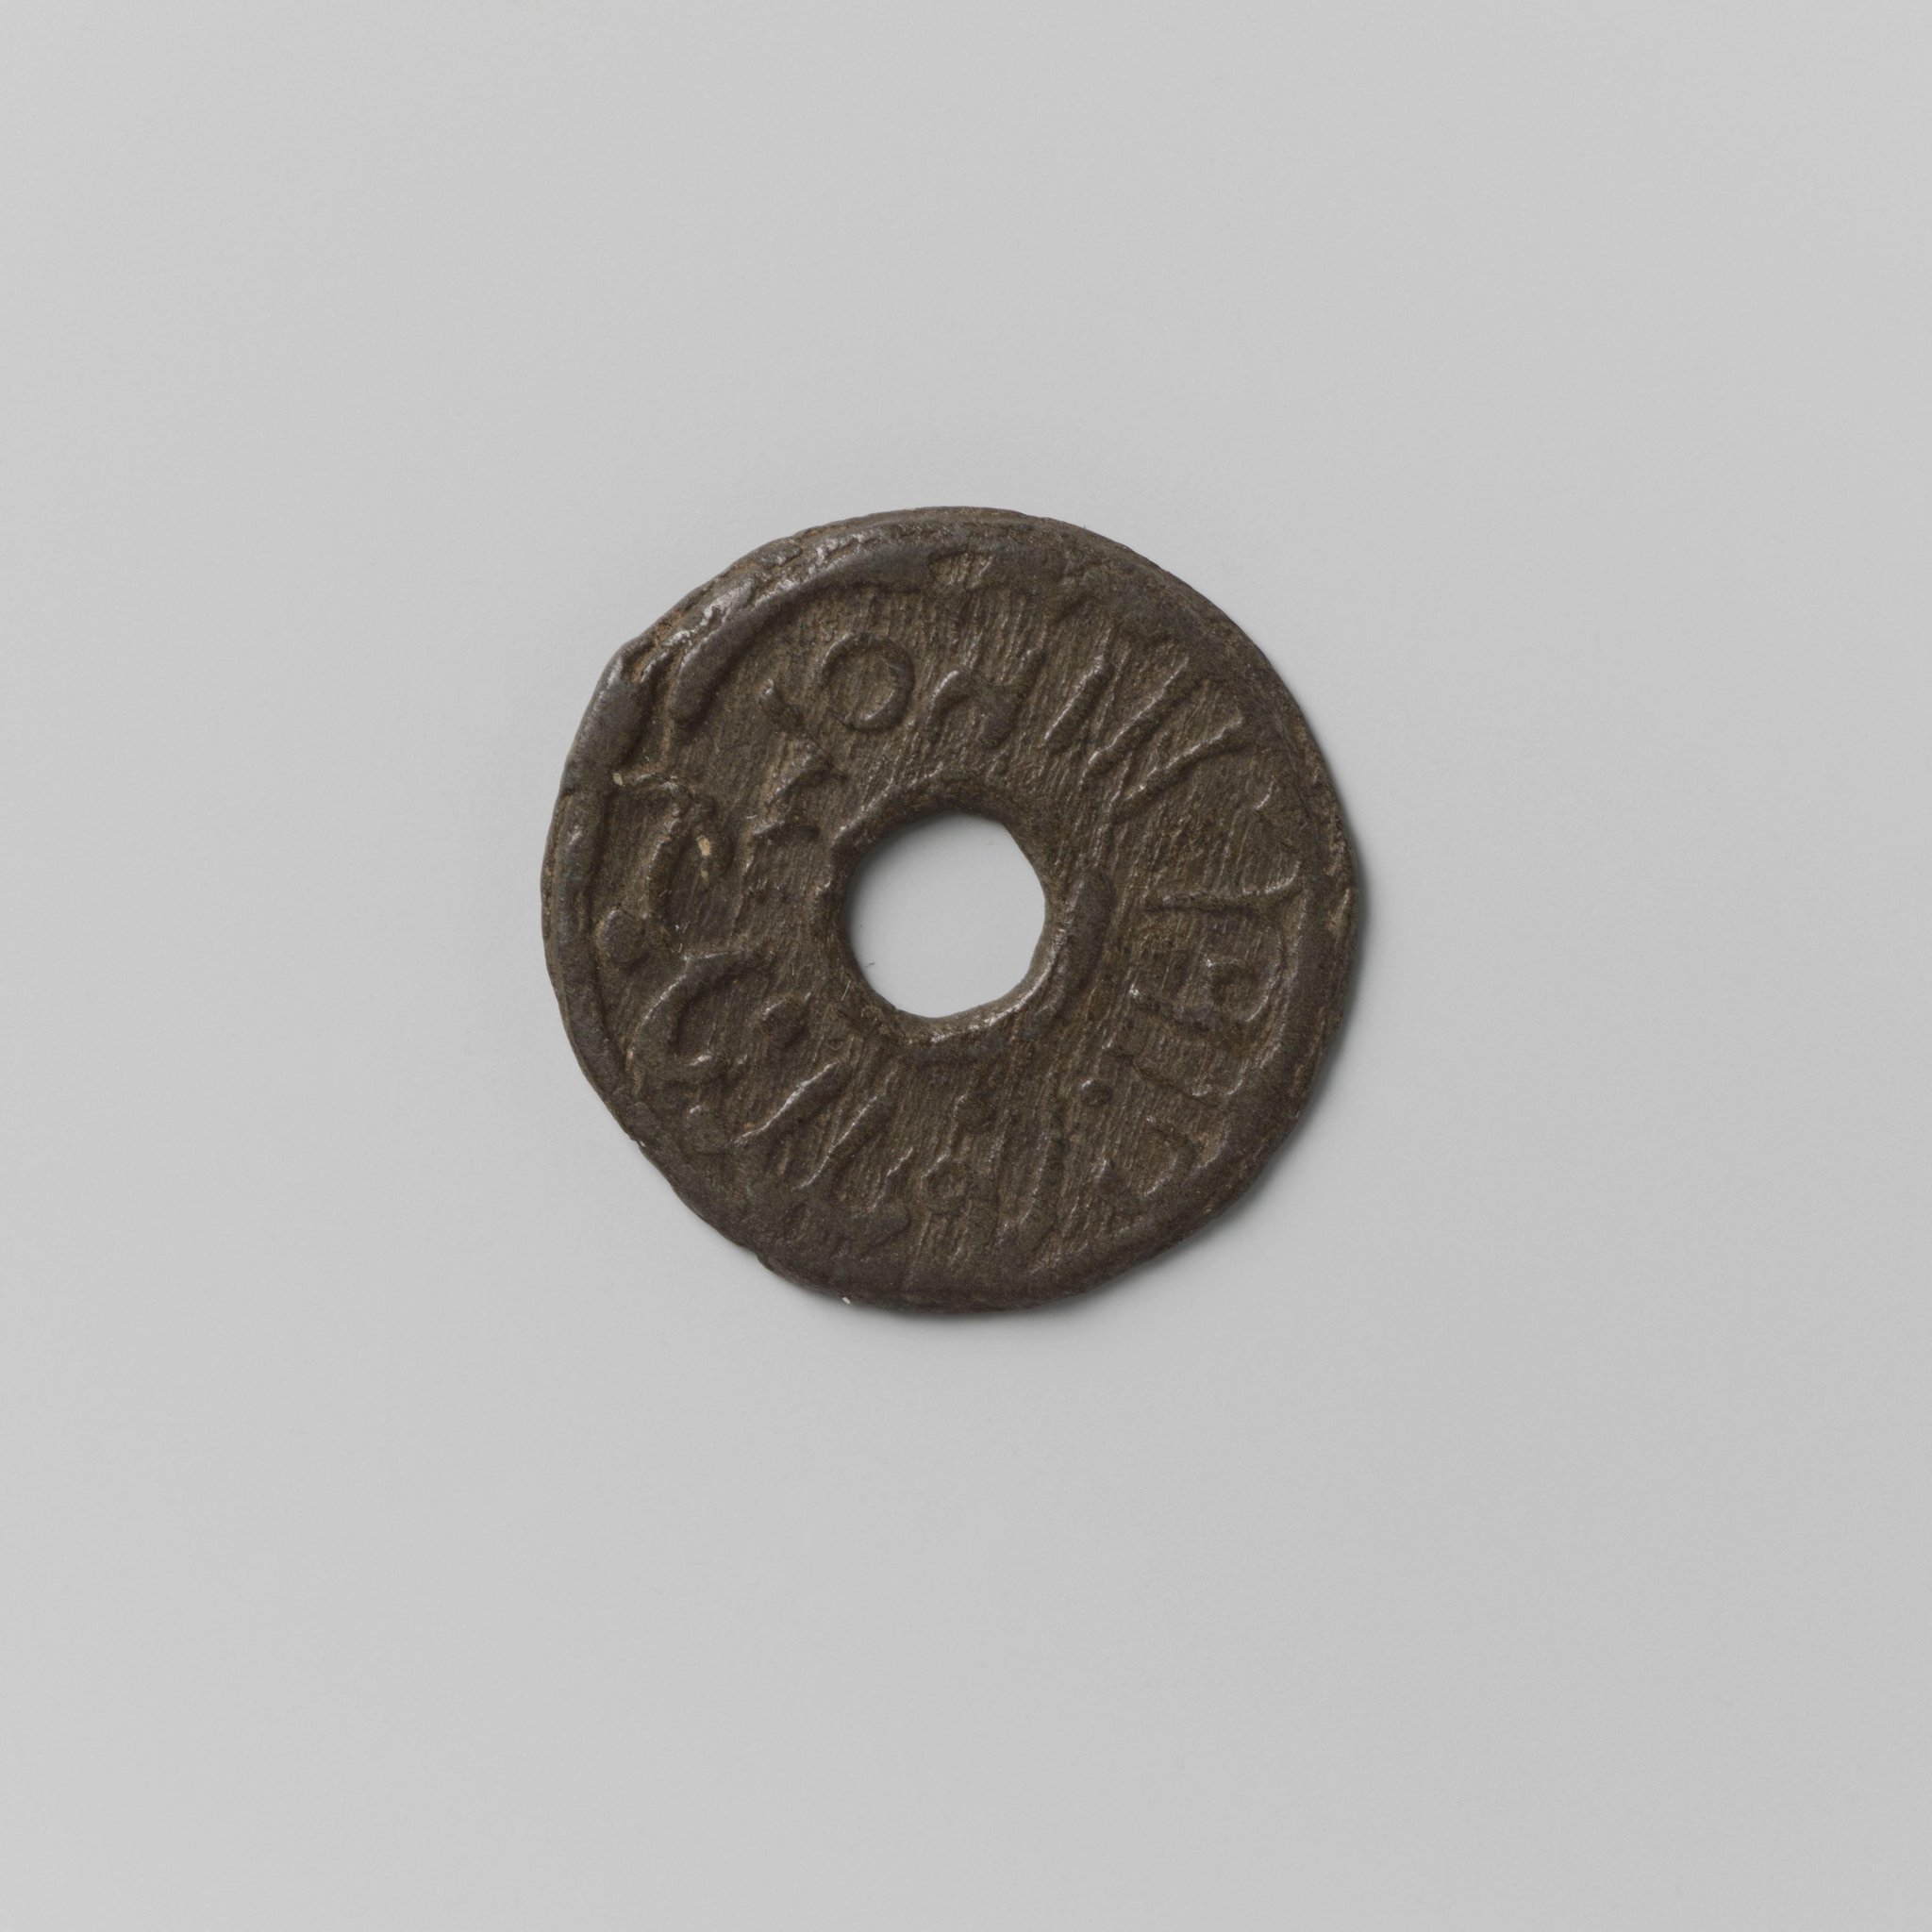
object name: coin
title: Palembang, Sumatra, sultan Mohammed Beha ed-din, pitji, A.H. 1203 (1788)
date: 1788-1789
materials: tin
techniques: casting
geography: palembang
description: Tinnen munt. Voorzijde: omschrift in Arabische lettertekens, waartussen jaartal in Islamitische jaartelling. Keerzijde, glad. In het midden rond gat.